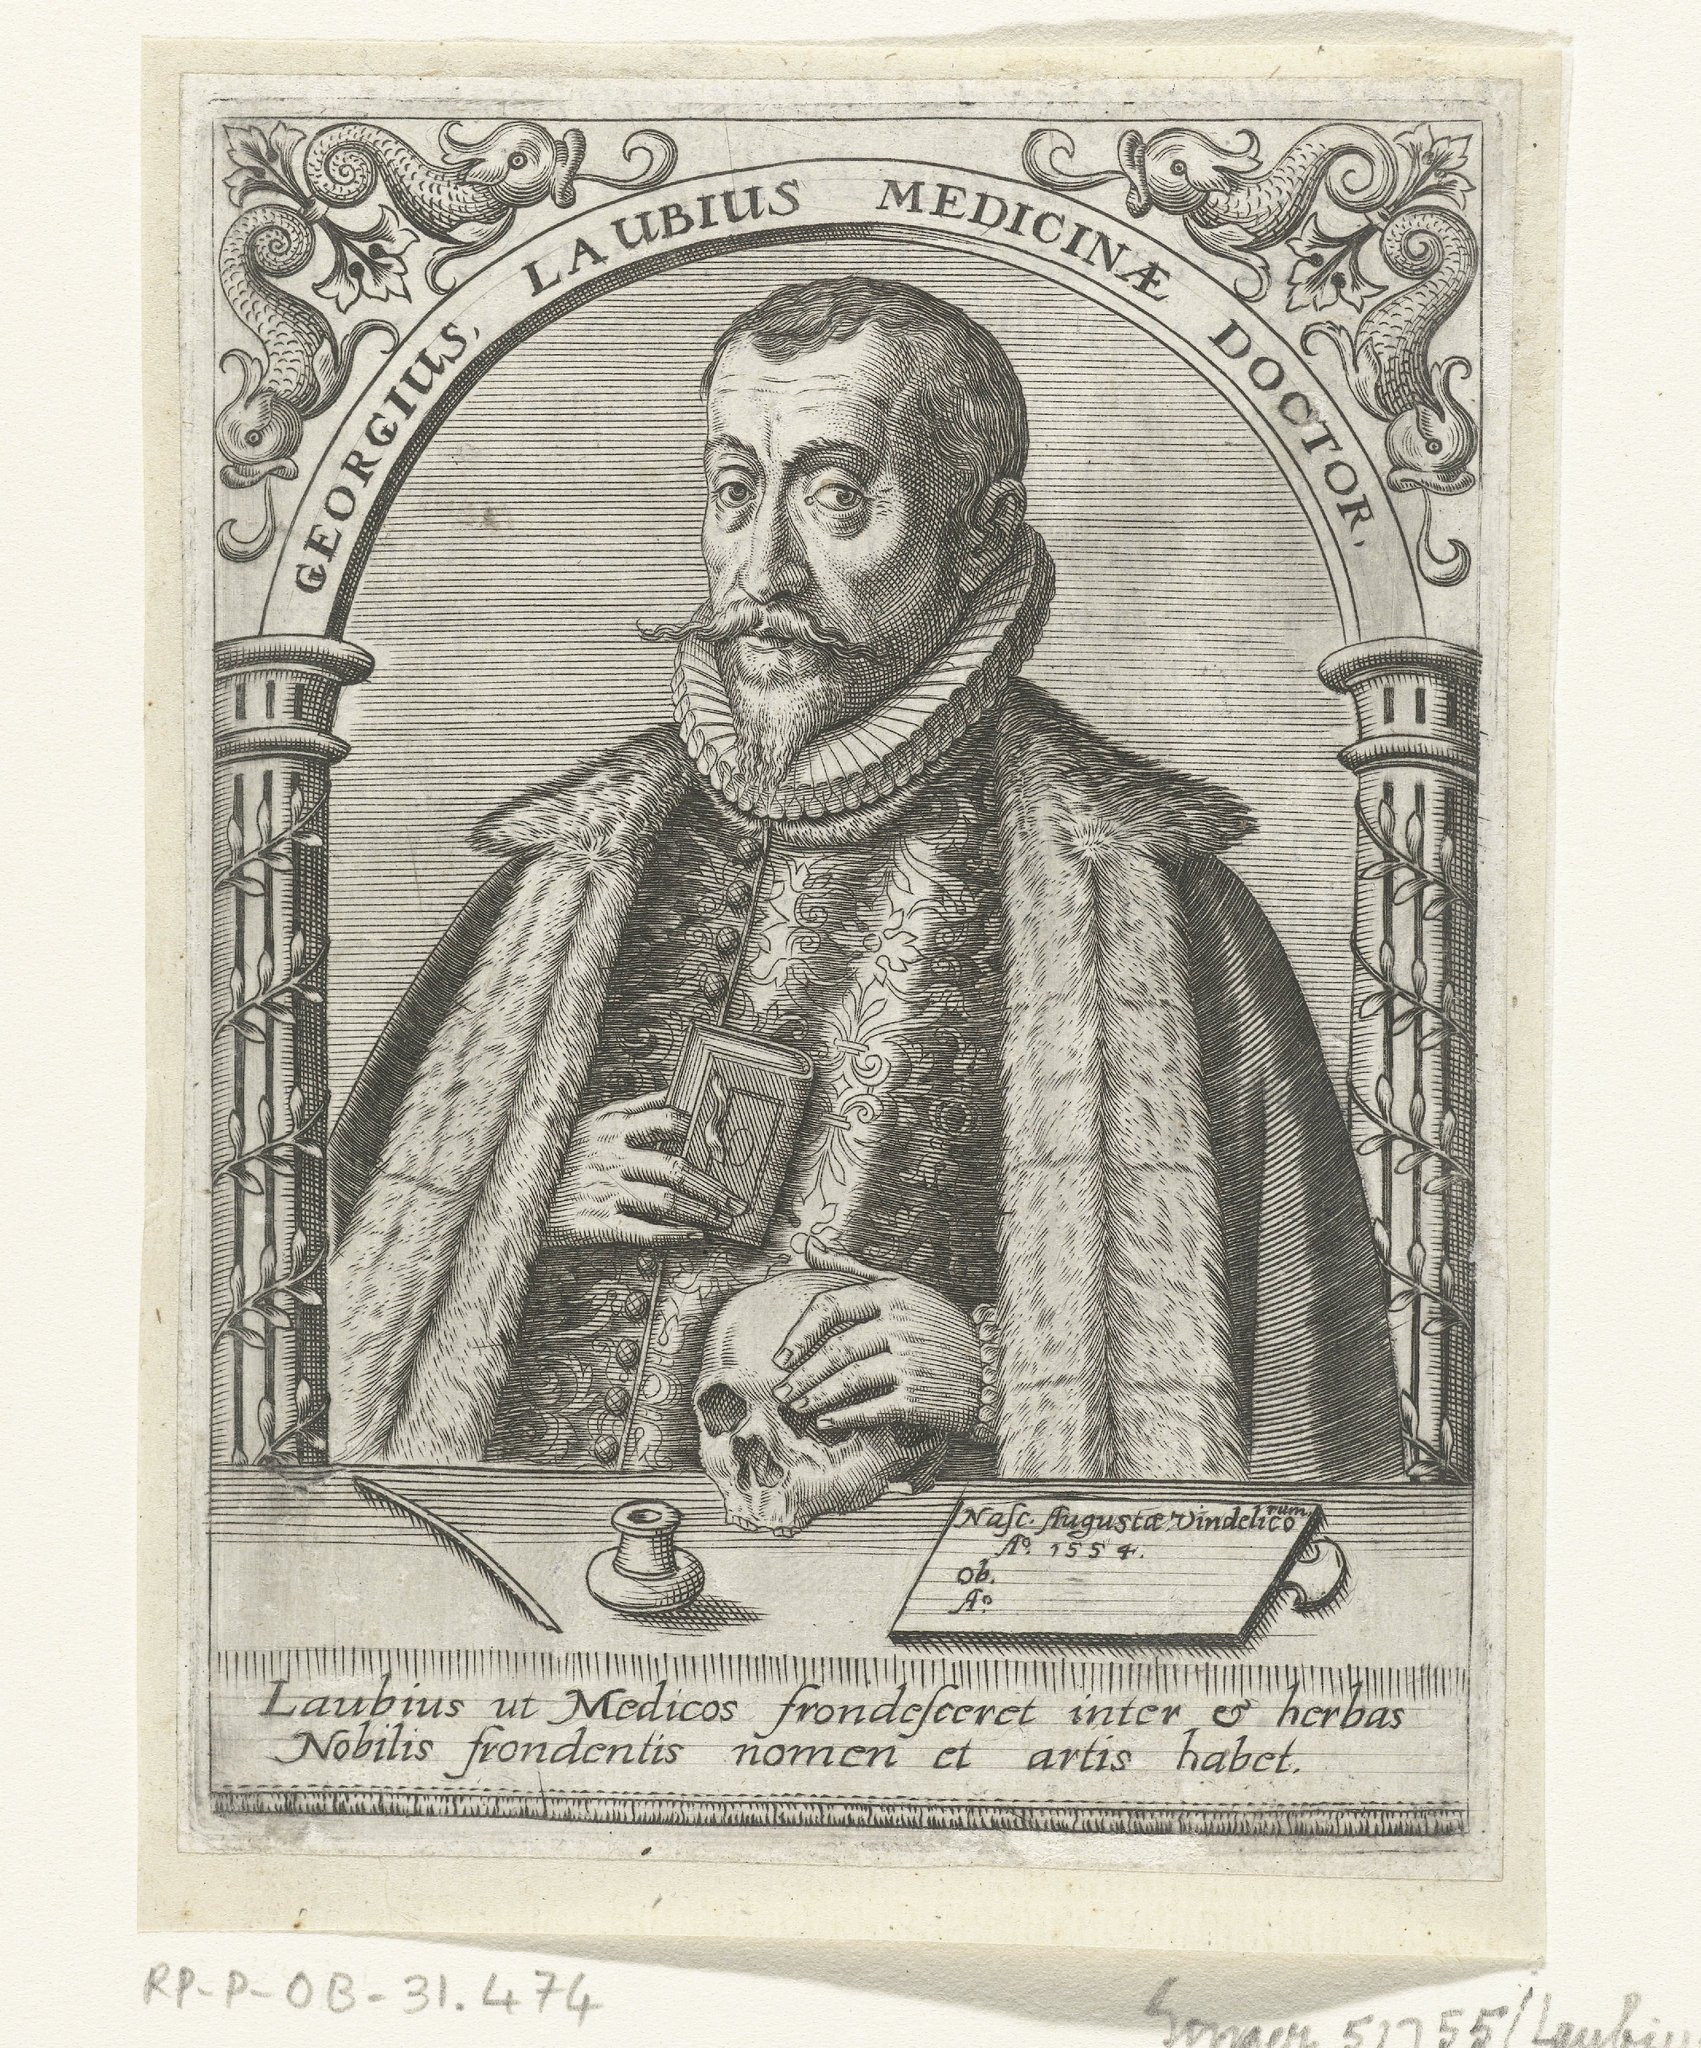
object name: book illustration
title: Georgius Laubius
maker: jean jacques boissard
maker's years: 1528-1598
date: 1597-1599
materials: paper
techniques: engraving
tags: arts, georg laub (i)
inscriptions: collector's mark: Lugt 2228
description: Gemaakt voor: J.J. Boissard, Icones virorum illustrium doctrina &c eruditione praestanti um contines. Frankfurt am Main: de Bry, 1597-1599.